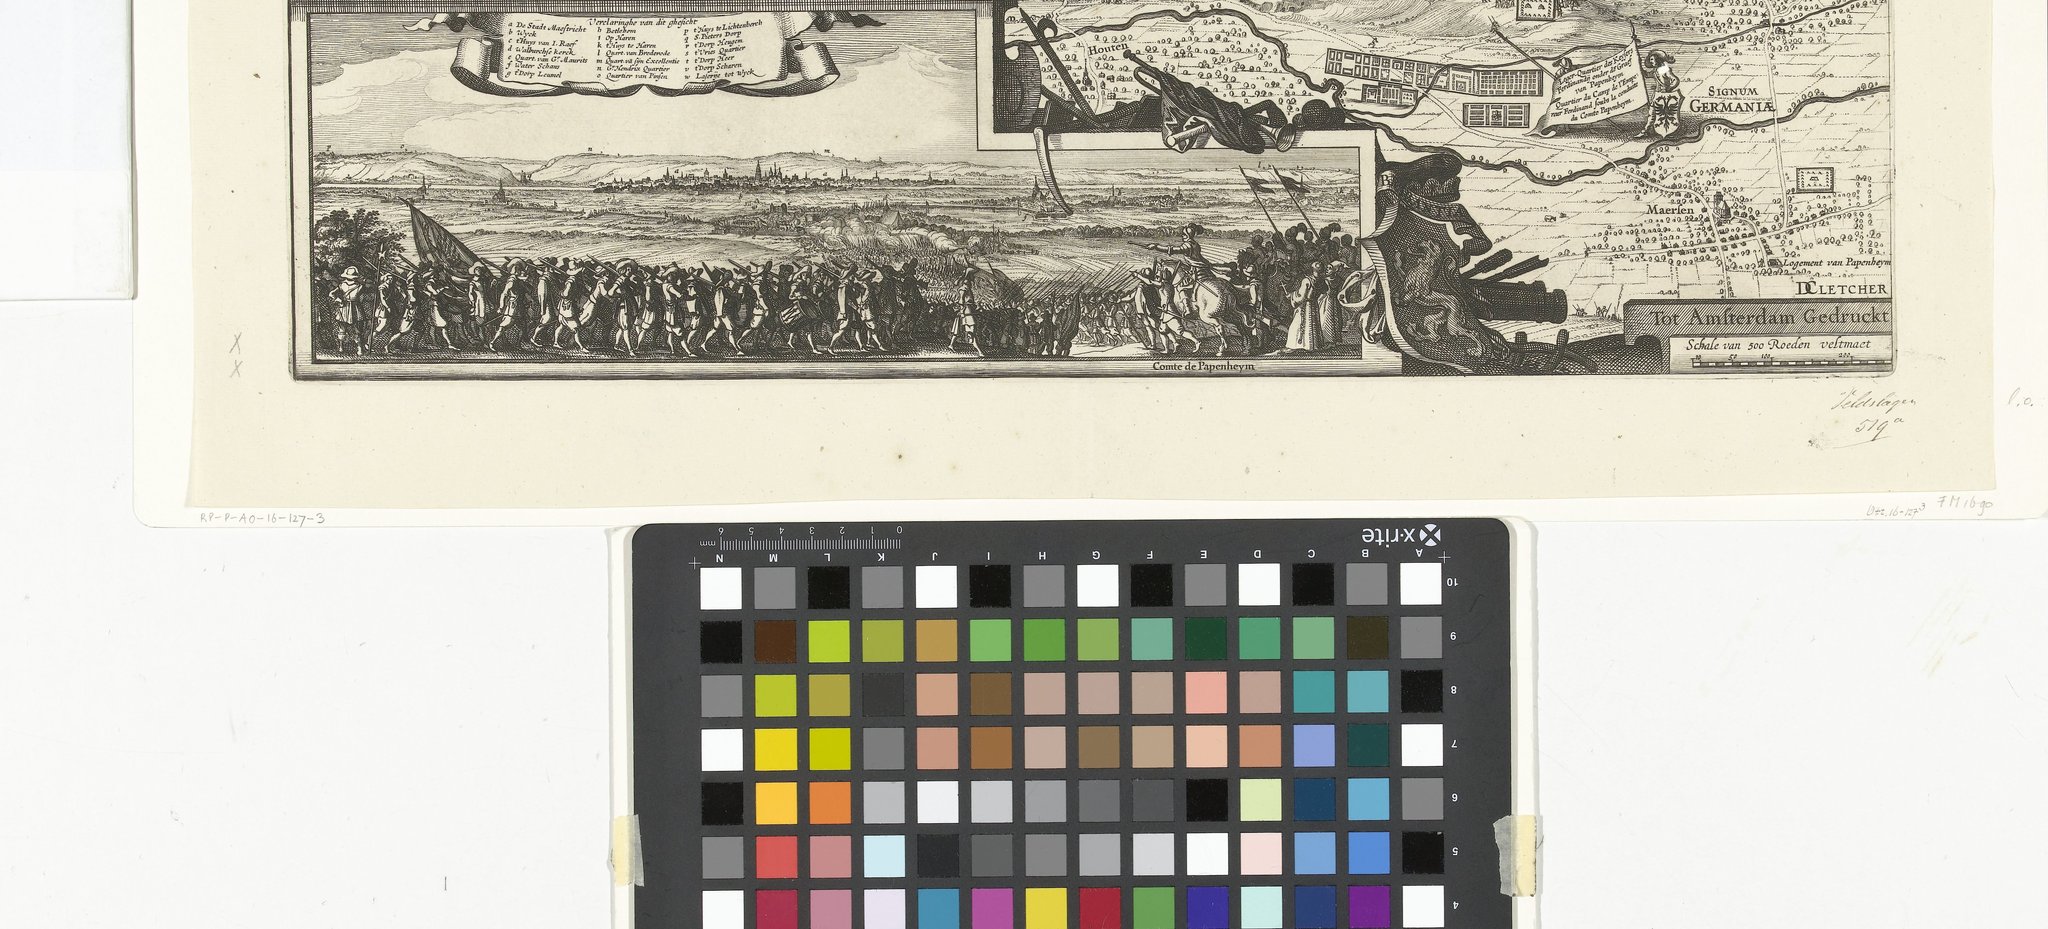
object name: print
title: Beleg van Maastricht, 1632 (plaat 3)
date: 1633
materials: paper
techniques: etching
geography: the hague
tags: delft, frederick henry (prince of orange), maps of separate countries or regions, siege, position war, maastricht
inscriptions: collector's mark, inscription: ‘Veldslagen 519a’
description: Kaart van het beleg en de inname van Maastricht door het Staatse leger onder stadhouder Frederik Hendrik, 9 juni tot 21 augustus 1632. Kaart samengesteld uit zes bladen, drie links en drie rechts. Dit is het blad linksmidden. In de hoek de afgeslagen aanval op de belegerende troepen door het leger van de graaf van Pappenheim op 17 augustus.